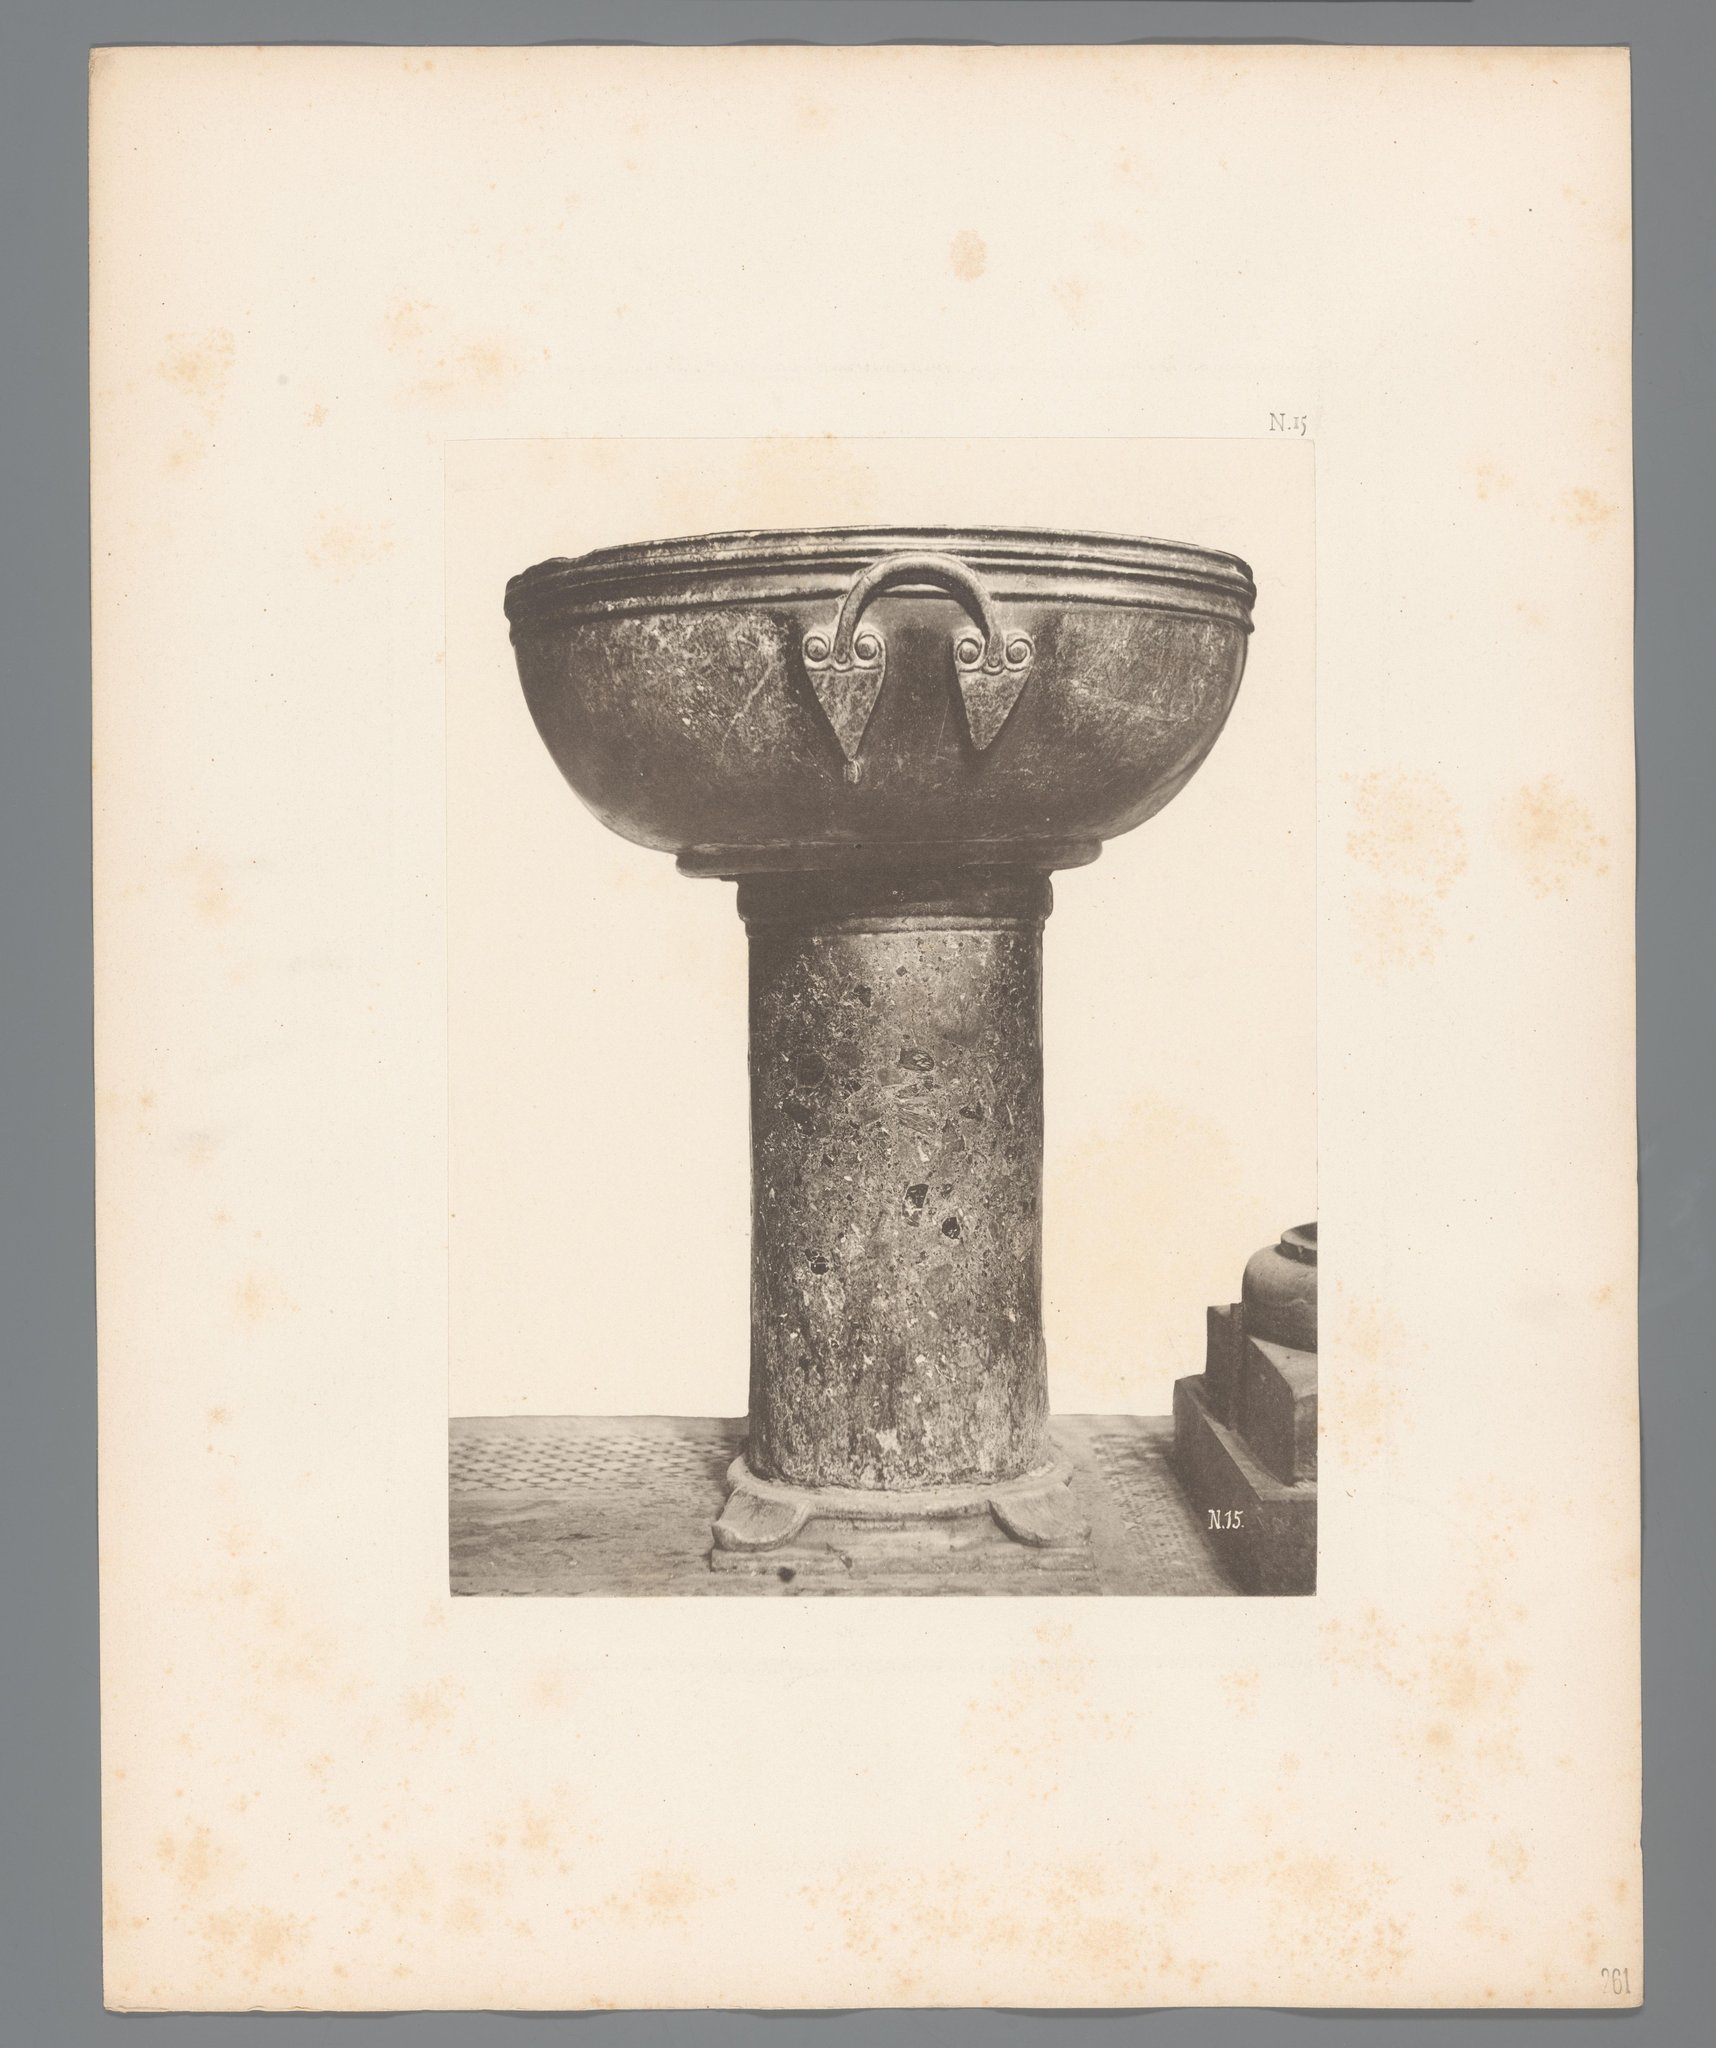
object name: photomechanical print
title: Vont met wijwater in de San Marco in Venetië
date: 1880-1885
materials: paper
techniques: photograph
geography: st. mark's basilica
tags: holy water font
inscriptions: number: ‘N.15’, number: ‘261’, number: ‘N.15.’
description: Deze prent maakt deel uit van een omslag met 58 prenten op 50 bladen.